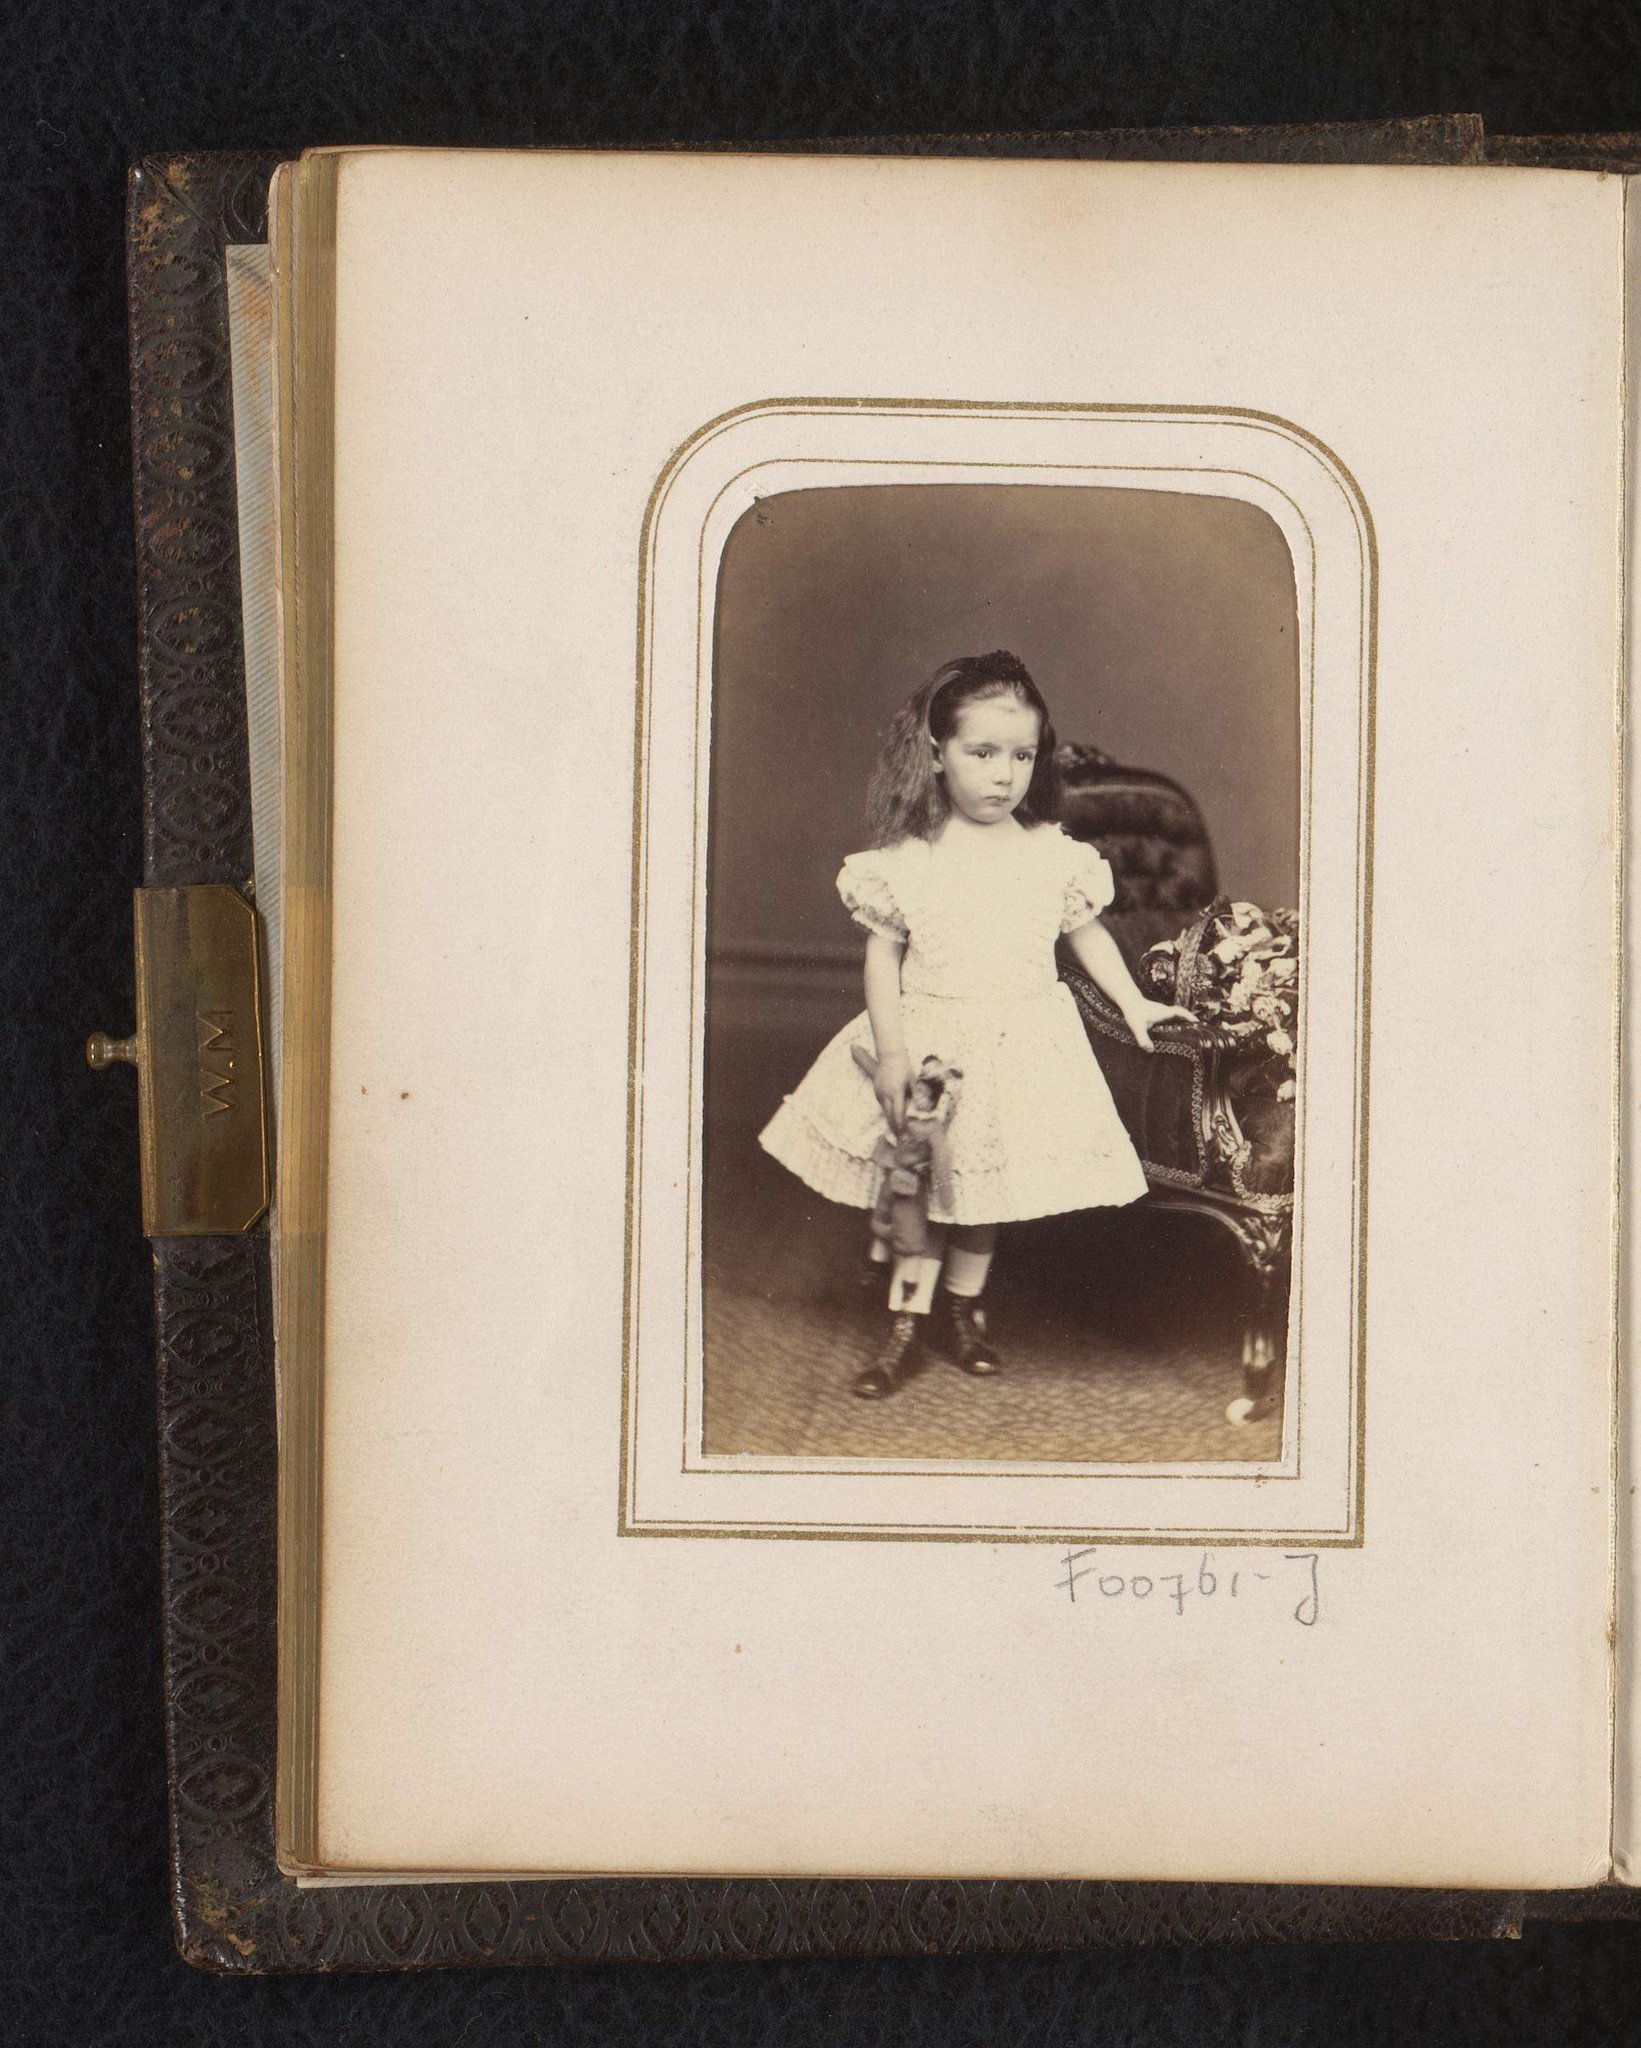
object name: album leaf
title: Portret van een meisje met pop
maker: john jabez edwin mayall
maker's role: fotograaf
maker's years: 1813-1901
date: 1846-1865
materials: cardboard, photographic support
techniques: albumen print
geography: london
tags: girl (child between toddler and youth), (playing with) dolls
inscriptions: inscription: ‘Mayall/ 91, King's Road Brighton/ 224, Regent Street/ London W.’